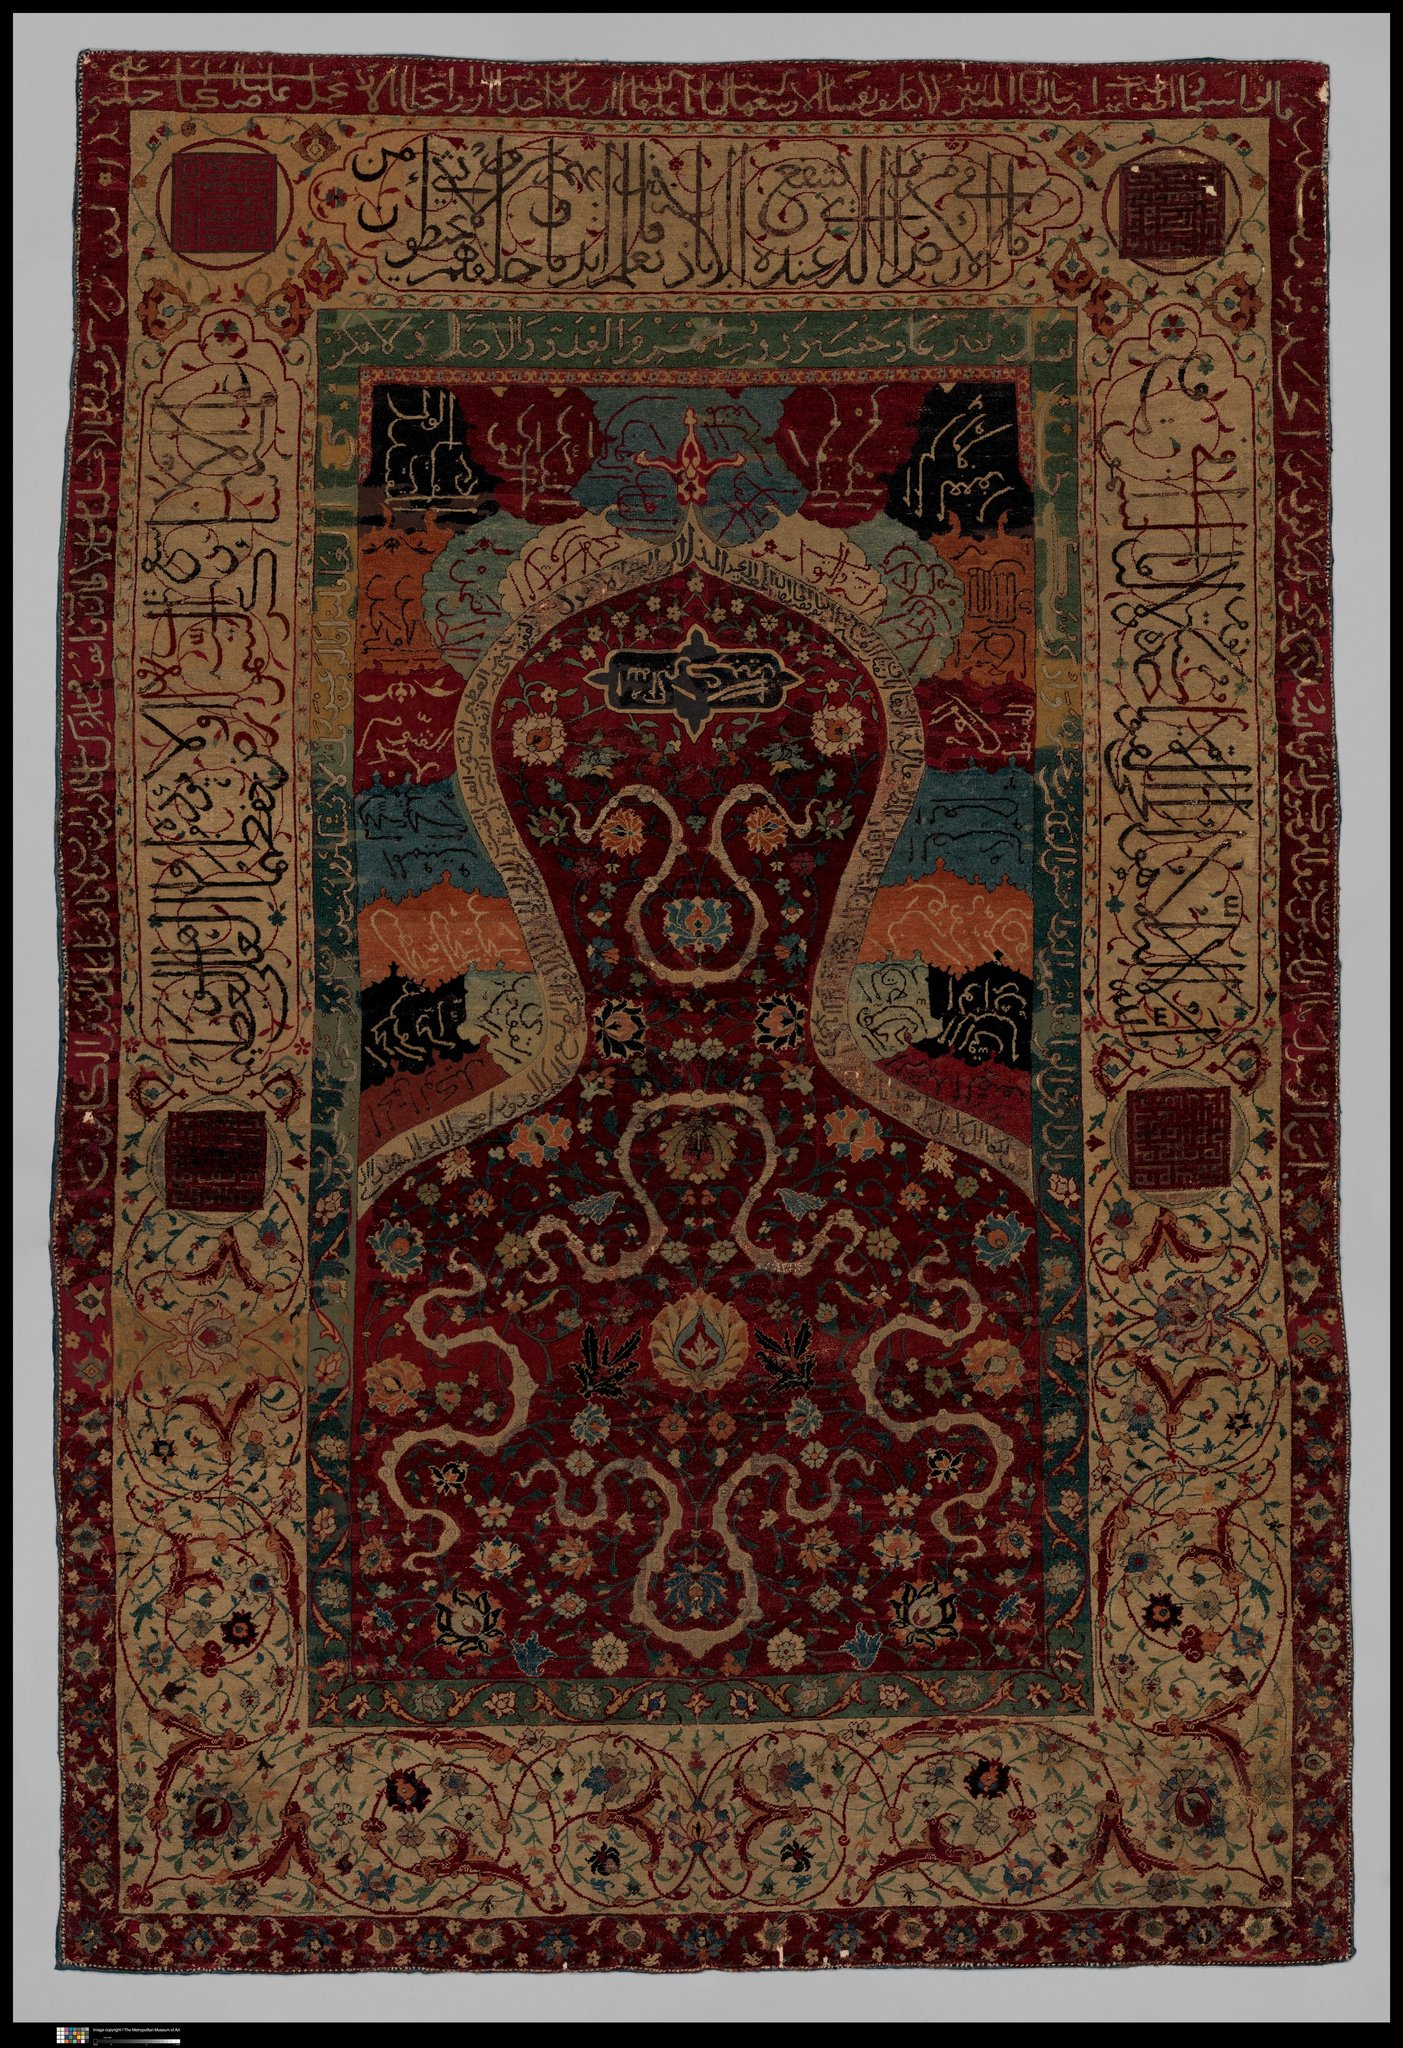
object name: carpet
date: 1501-1600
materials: metal thread, silk, thread, wool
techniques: brocade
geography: iran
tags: arabic,flowers